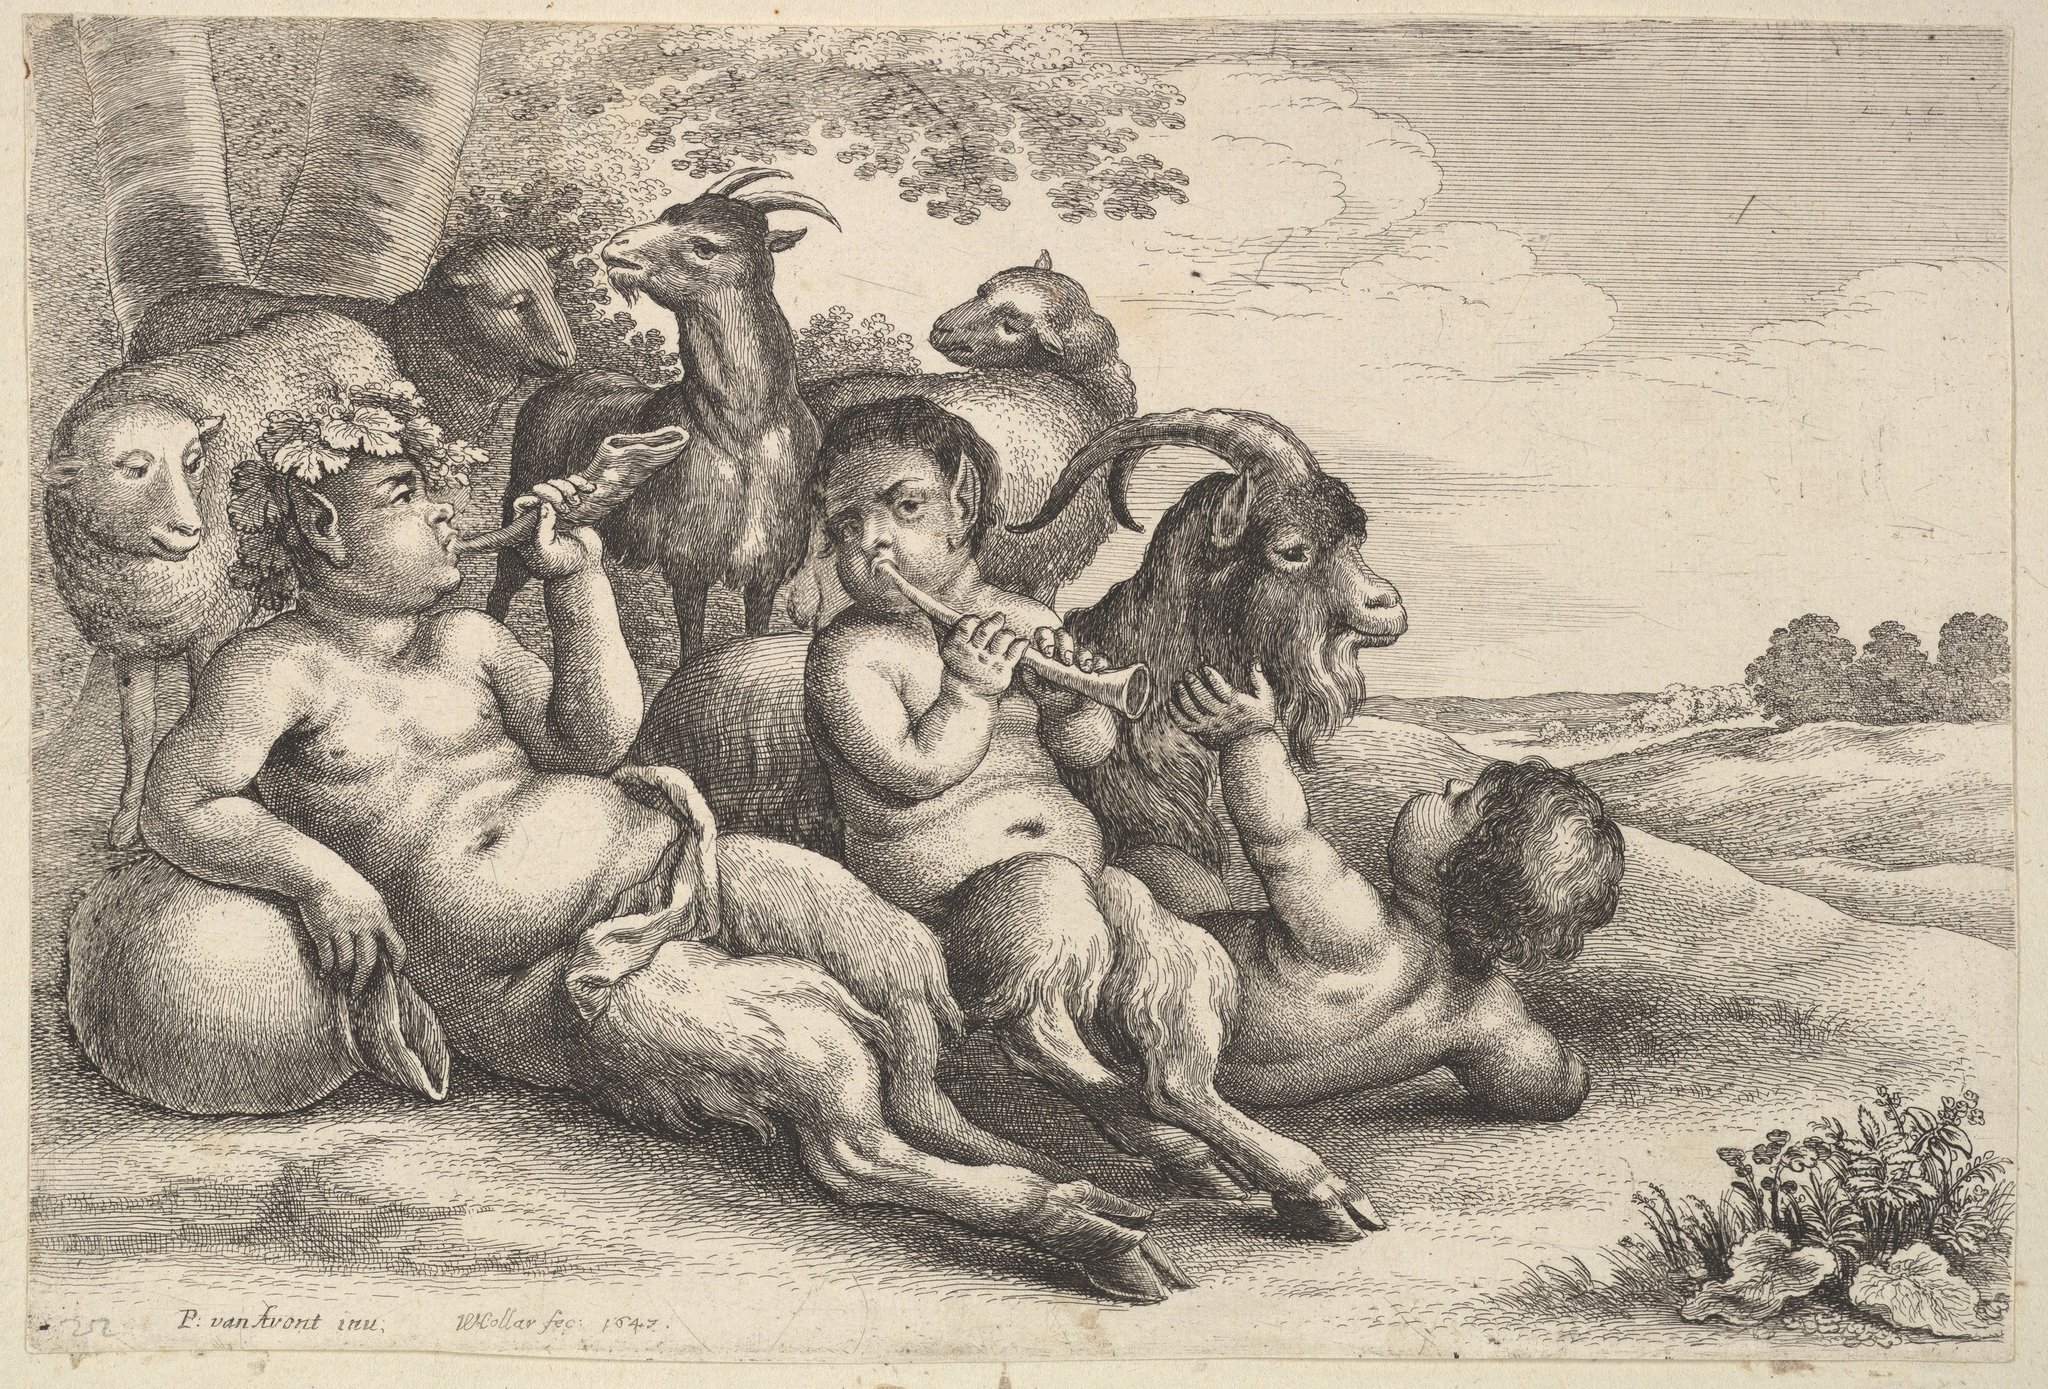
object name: print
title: Two young satyrs and a boy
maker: wenceslaus hollar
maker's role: artist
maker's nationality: bohemian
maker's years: 1607-1677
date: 1647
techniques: etching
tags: musical instruments,boys,satyrs,goats,sheep